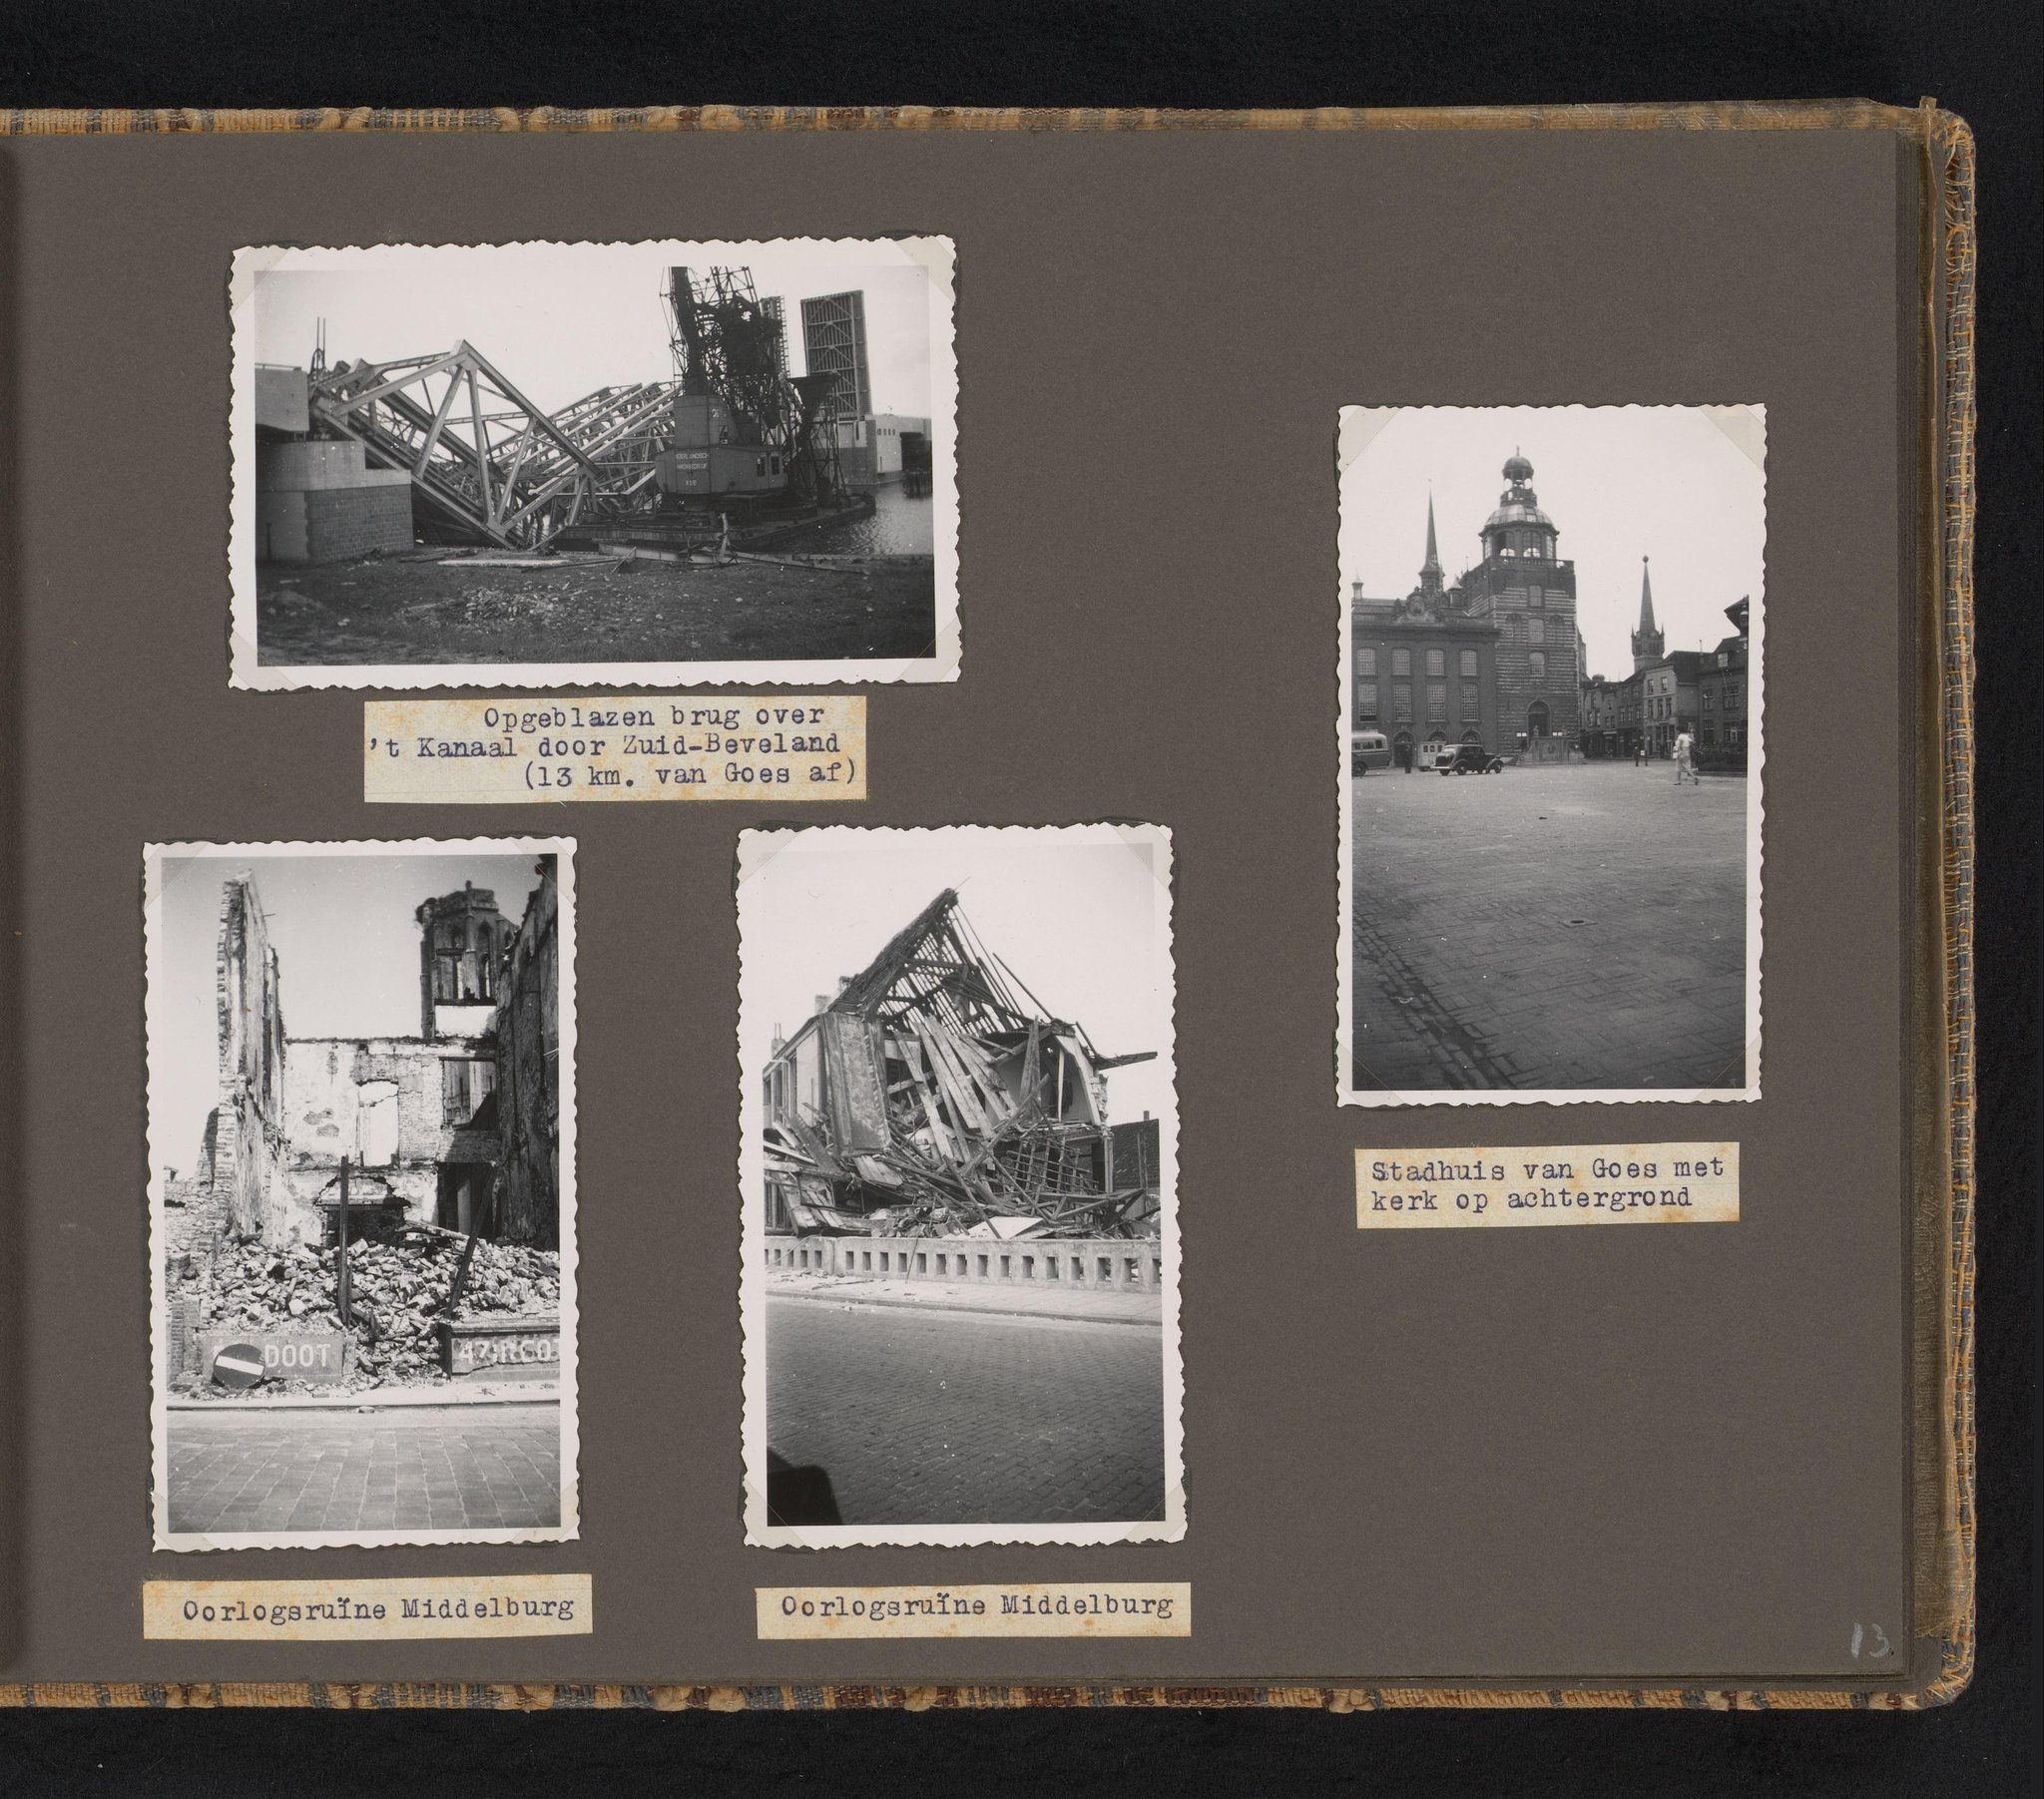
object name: album leaf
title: Oorlogsschade in Zeeland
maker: Anonymous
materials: paper, photographic support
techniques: gelatin silver print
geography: netherlands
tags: riding, cycling (recreation), father with son(s) (father-love), outing, pleasure trip, bicycle, devastated, ruined place or city (~ warfare), middelburg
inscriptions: inscription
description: Albumblad met vier foto's van oorlogsverwoestingen in Zuid-Beveland en Middelburg en van het stadhuis van Goes. Onder de foto's uitgeknipte papiertjes met getypte opschriften. Onderdeel van het eerste fotoalbum met foto's van de twee fietstochten van vader en zoon door Nederland in september 1939 en juli 1940 en een autotrip met het gezin door Nederland, België en Luxemburg in juni 1949.